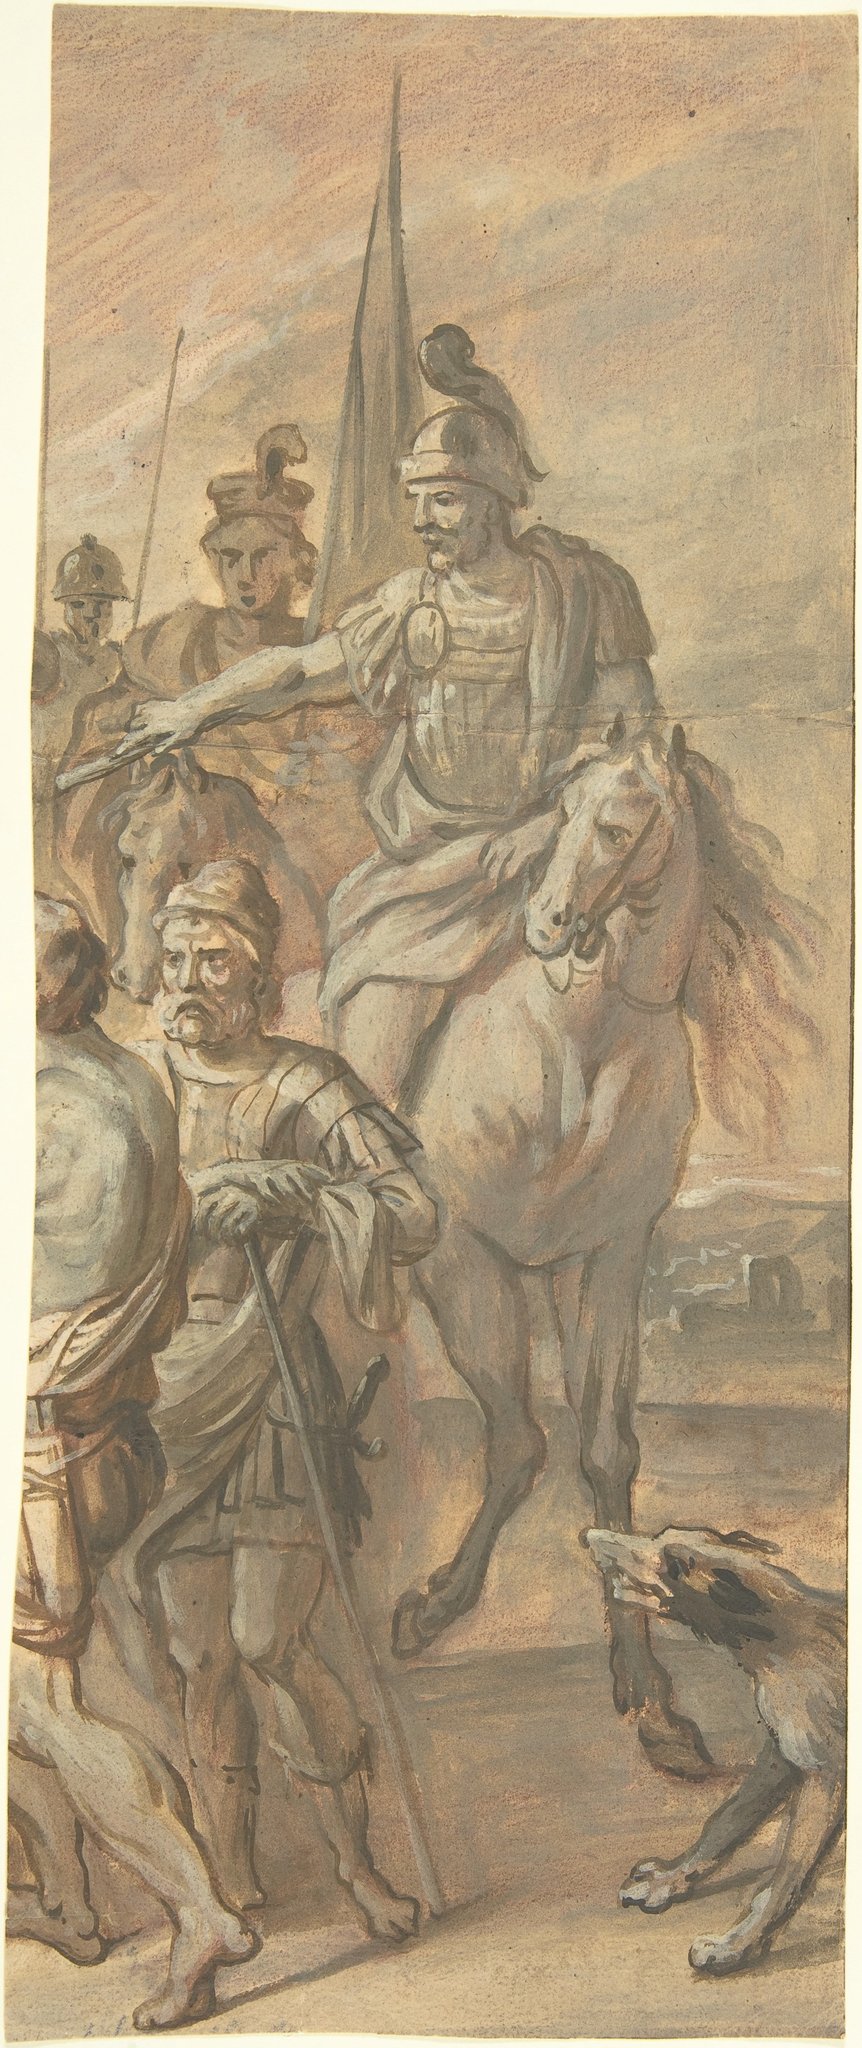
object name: drawing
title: Scene from the Life of Saint Bartholomew (fragment)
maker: erasmus quellinus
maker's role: artist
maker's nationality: flemish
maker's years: 1607-1678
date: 1620-1678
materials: paint, chalk, ink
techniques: brush, pen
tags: animals,soldiers,men,horses,saints